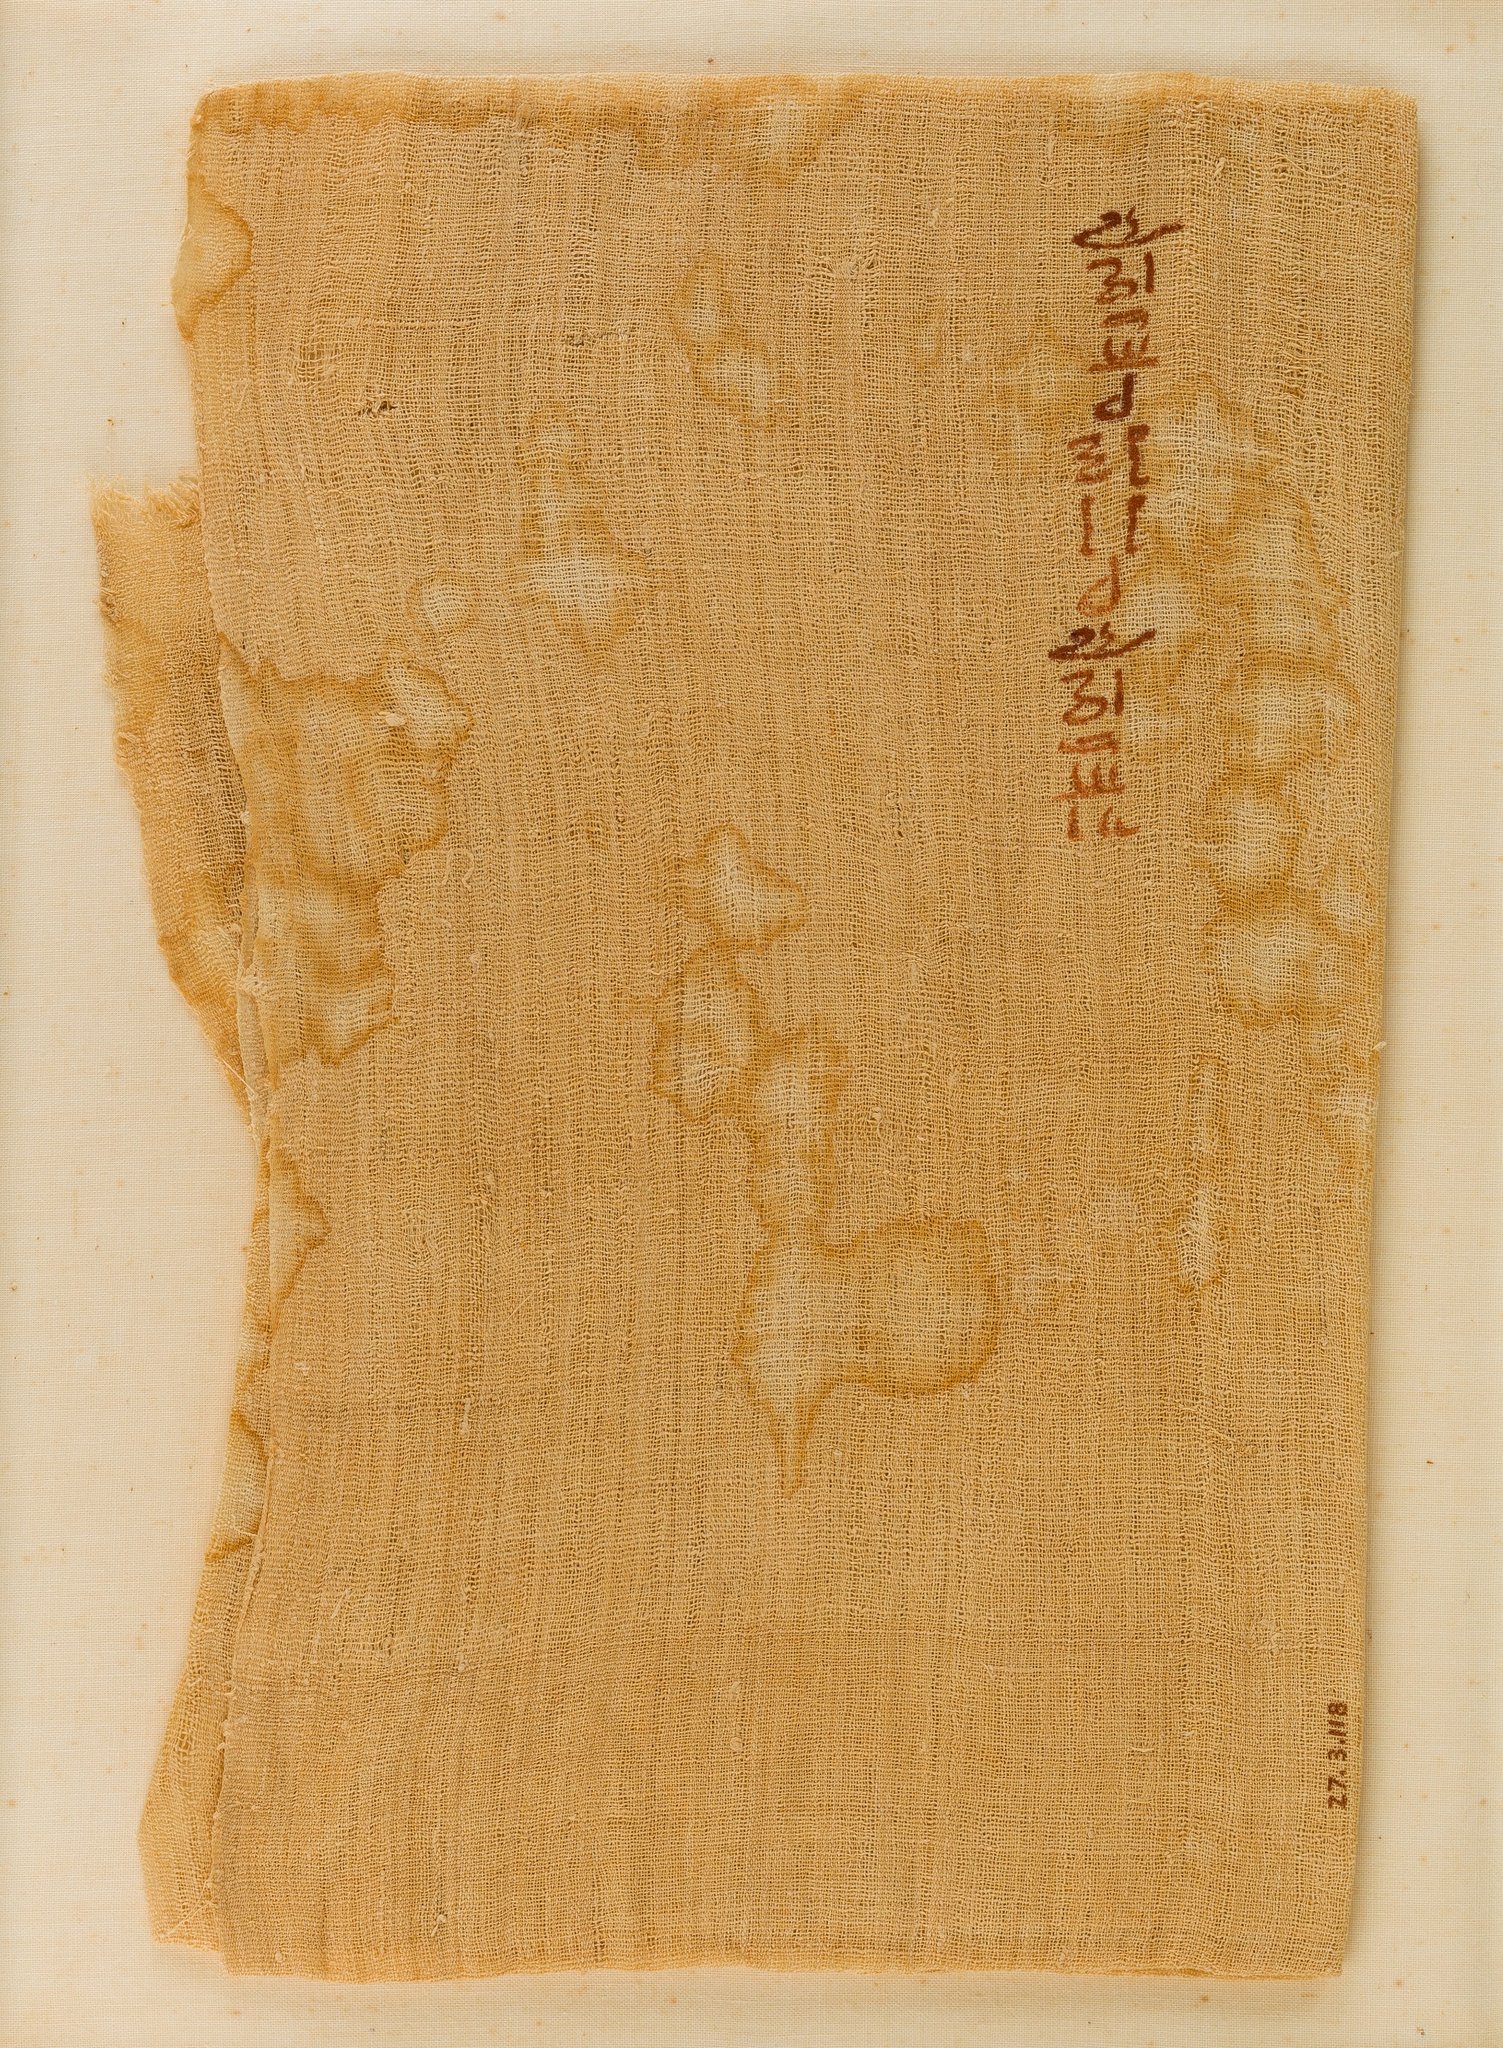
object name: linen, folded, linen mark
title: Folded Piece of Linen with Hieratic Inscription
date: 1961-1917 BCE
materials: linen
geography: egypt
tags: hieratic